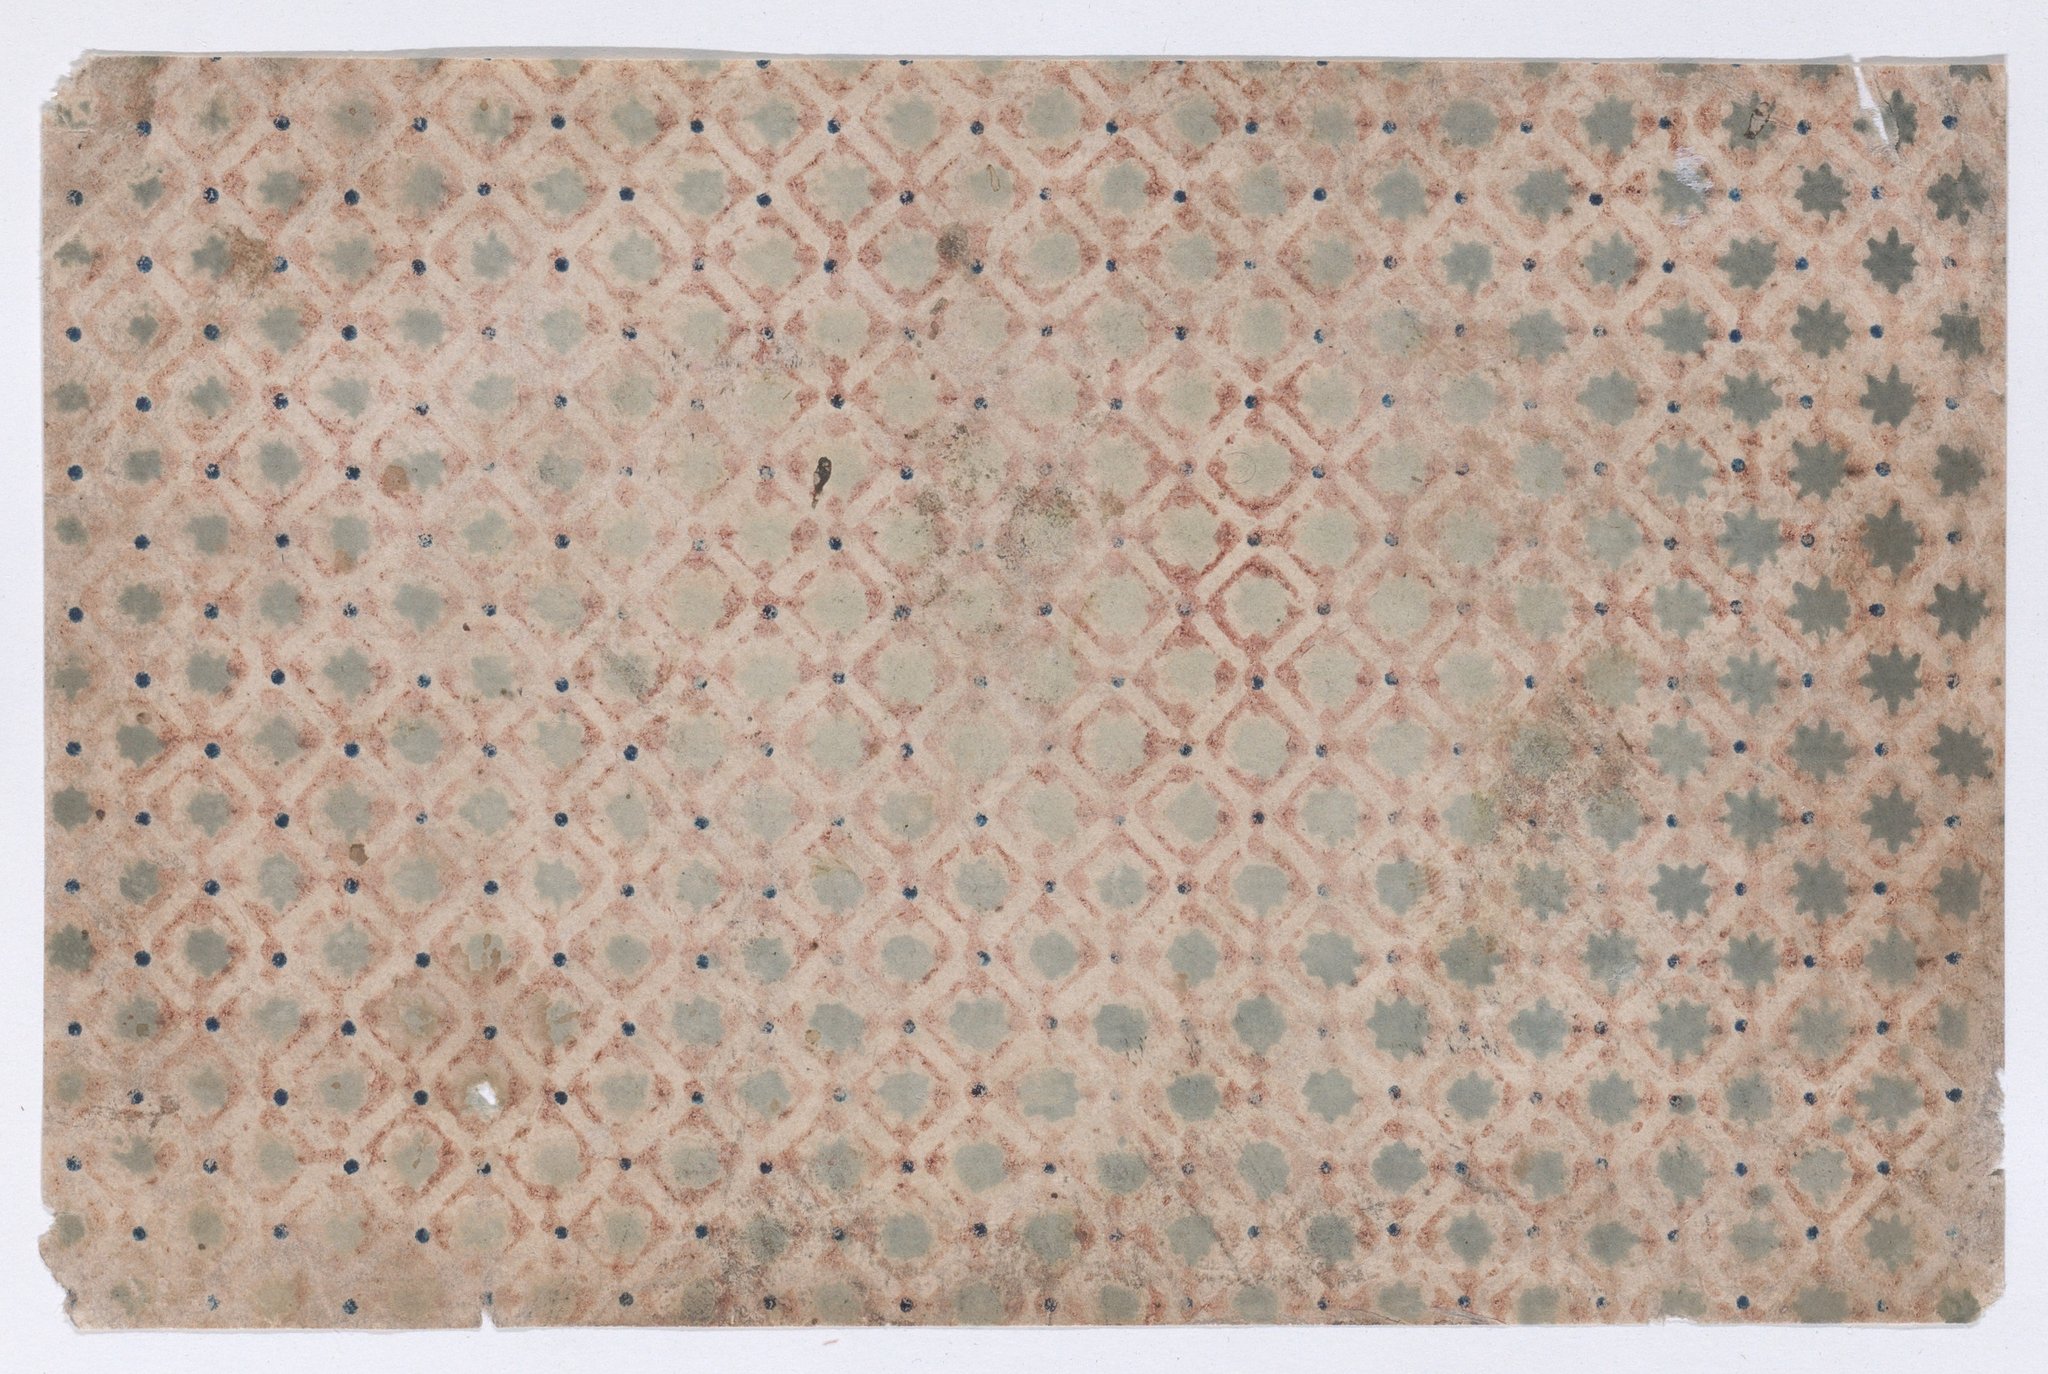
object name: print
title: Sheet with overall grid pattern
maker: Anonymous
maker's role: artist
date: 1801-1900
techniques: relief print